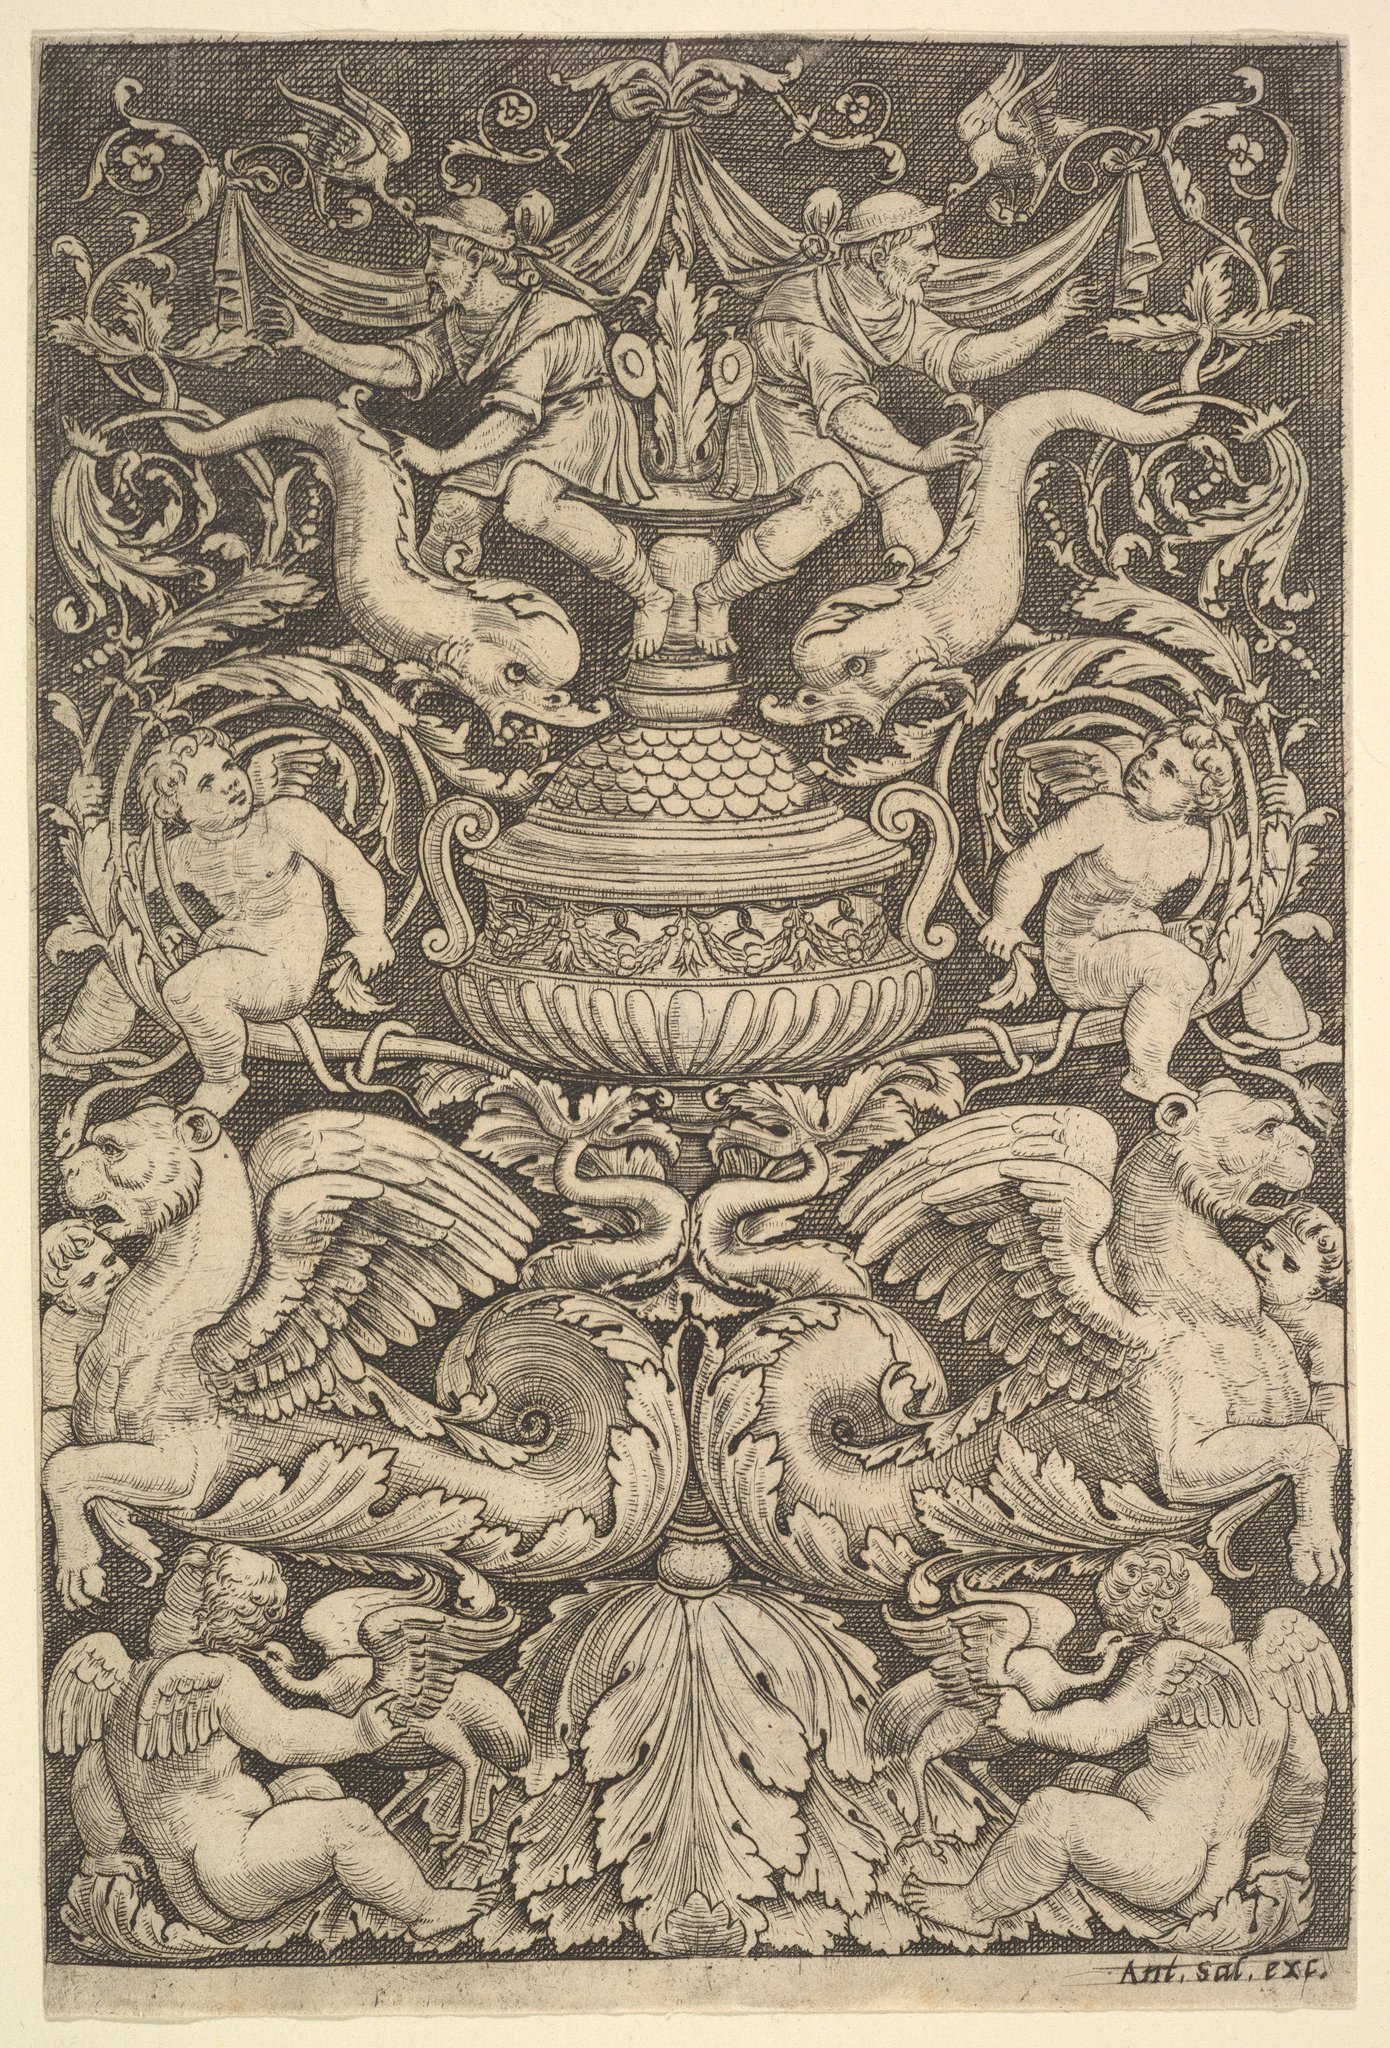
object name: print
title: A panel of ornament with a large jar in centre, putti and other figures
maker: master of the die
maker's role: artist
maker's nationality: italian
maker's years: 1525-1560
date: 1530-1560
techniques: engraving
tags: men,griffins,putti,dolphins